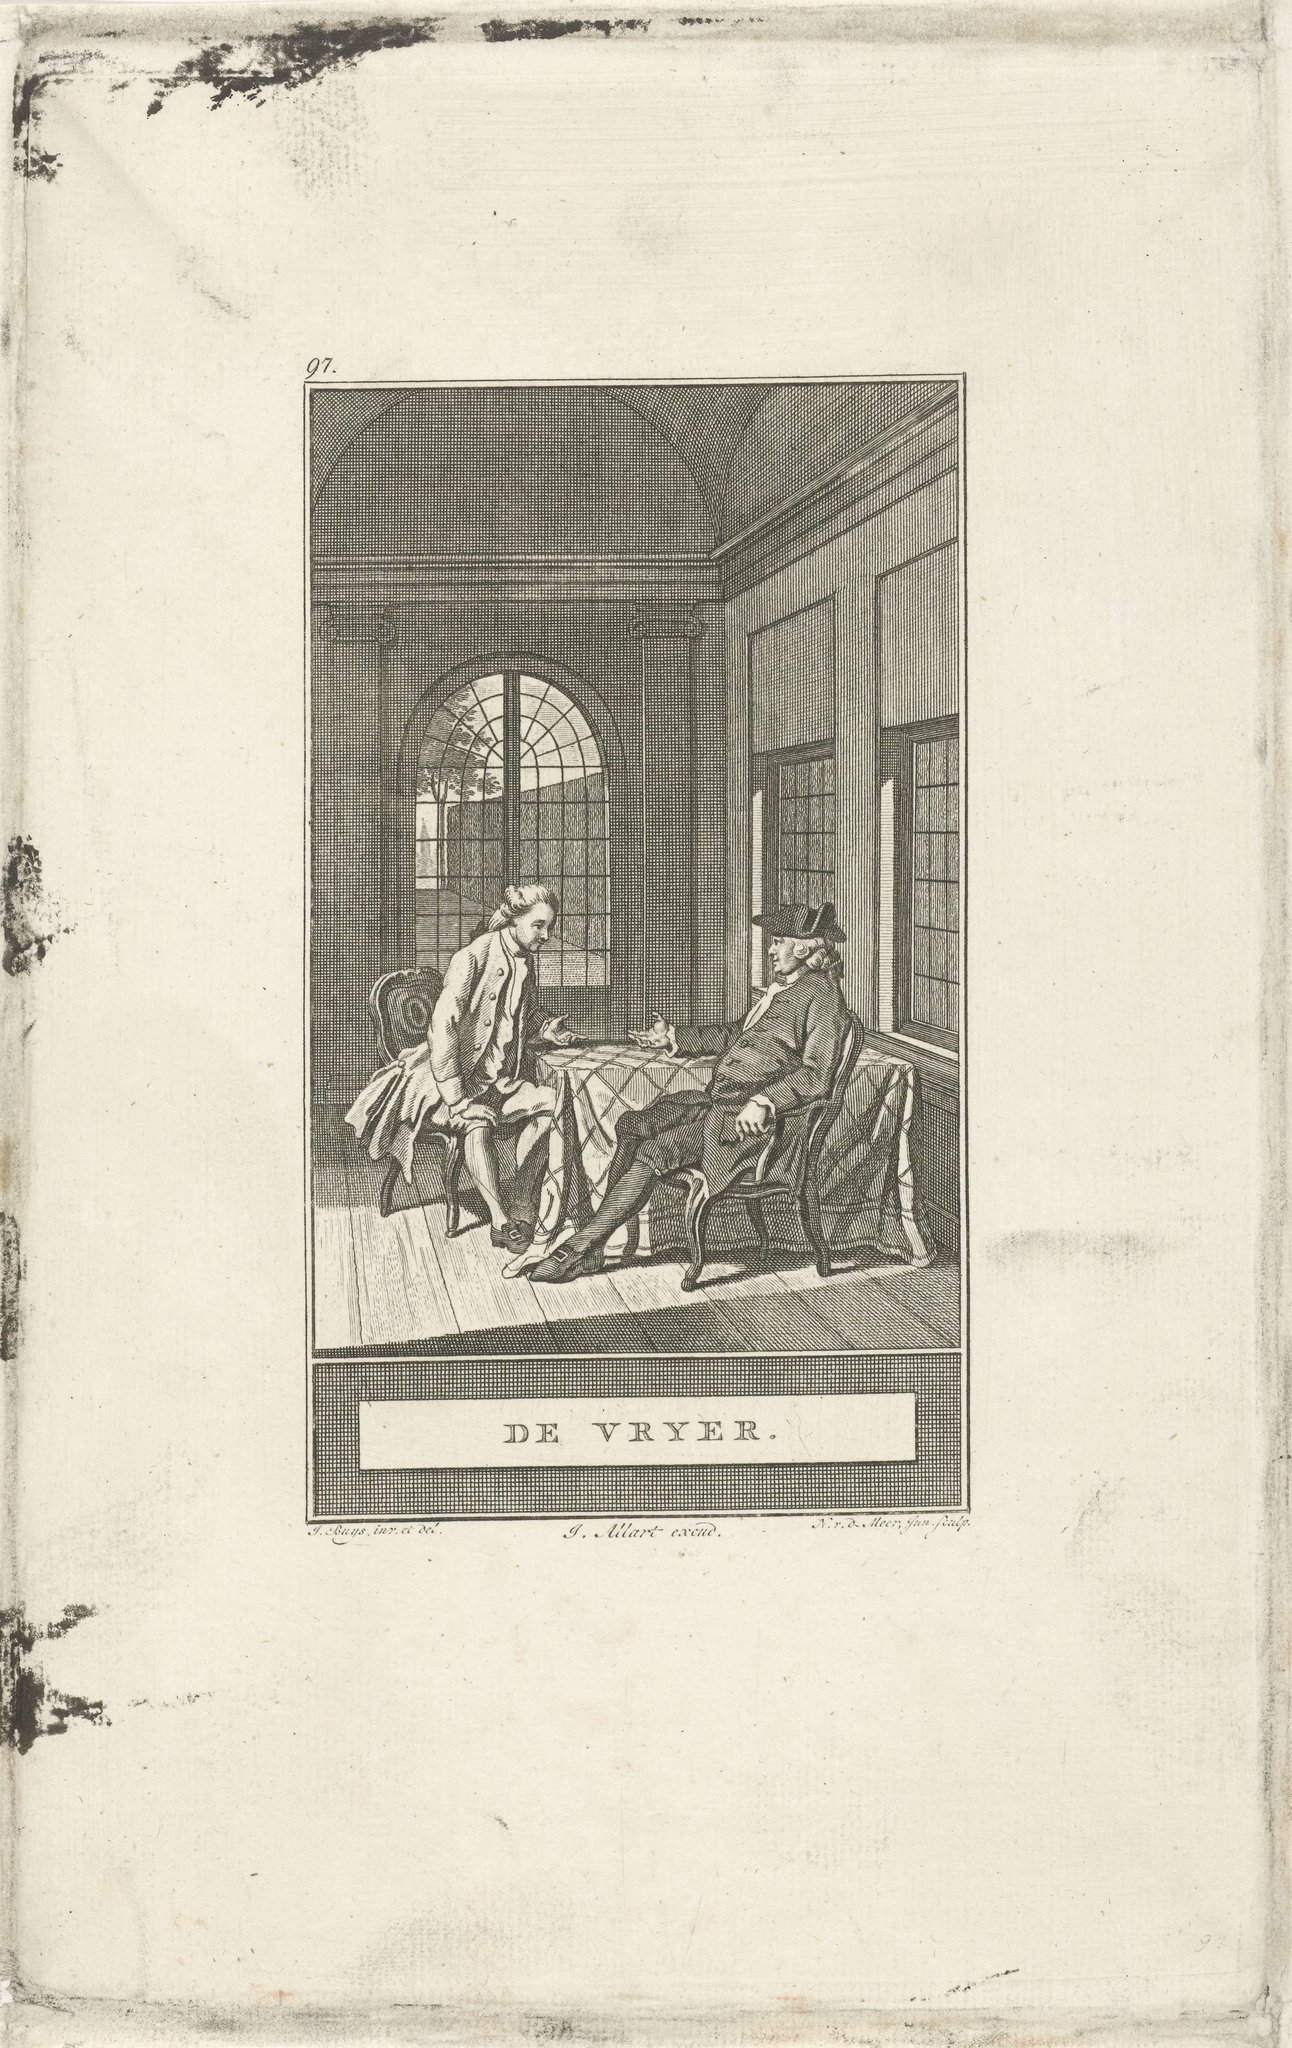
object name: print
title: Twee vrienden bij een tafel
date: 1778-1785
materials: paper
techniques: etching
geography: amsterdam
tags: table, conversation, dialogue; conversation piece, friends, closed window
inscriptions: collector's mark: Lugt 2228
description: Prent bij: Gellert, Christian Fürchtegott. Fabelen en vertelsels. 3 dln. Amsterdam: Pieter Meyer, 1772-1774. De prenten bij deze publicatie werden later uitgegeven. De exemplaren uitgegeven door de weduwe Jacobus Loveringh & Johannes Allart tussen 1777 en 1778, de exemplaren uitgegeven door alleen Johannes Allart tussen 1778 en 1785.